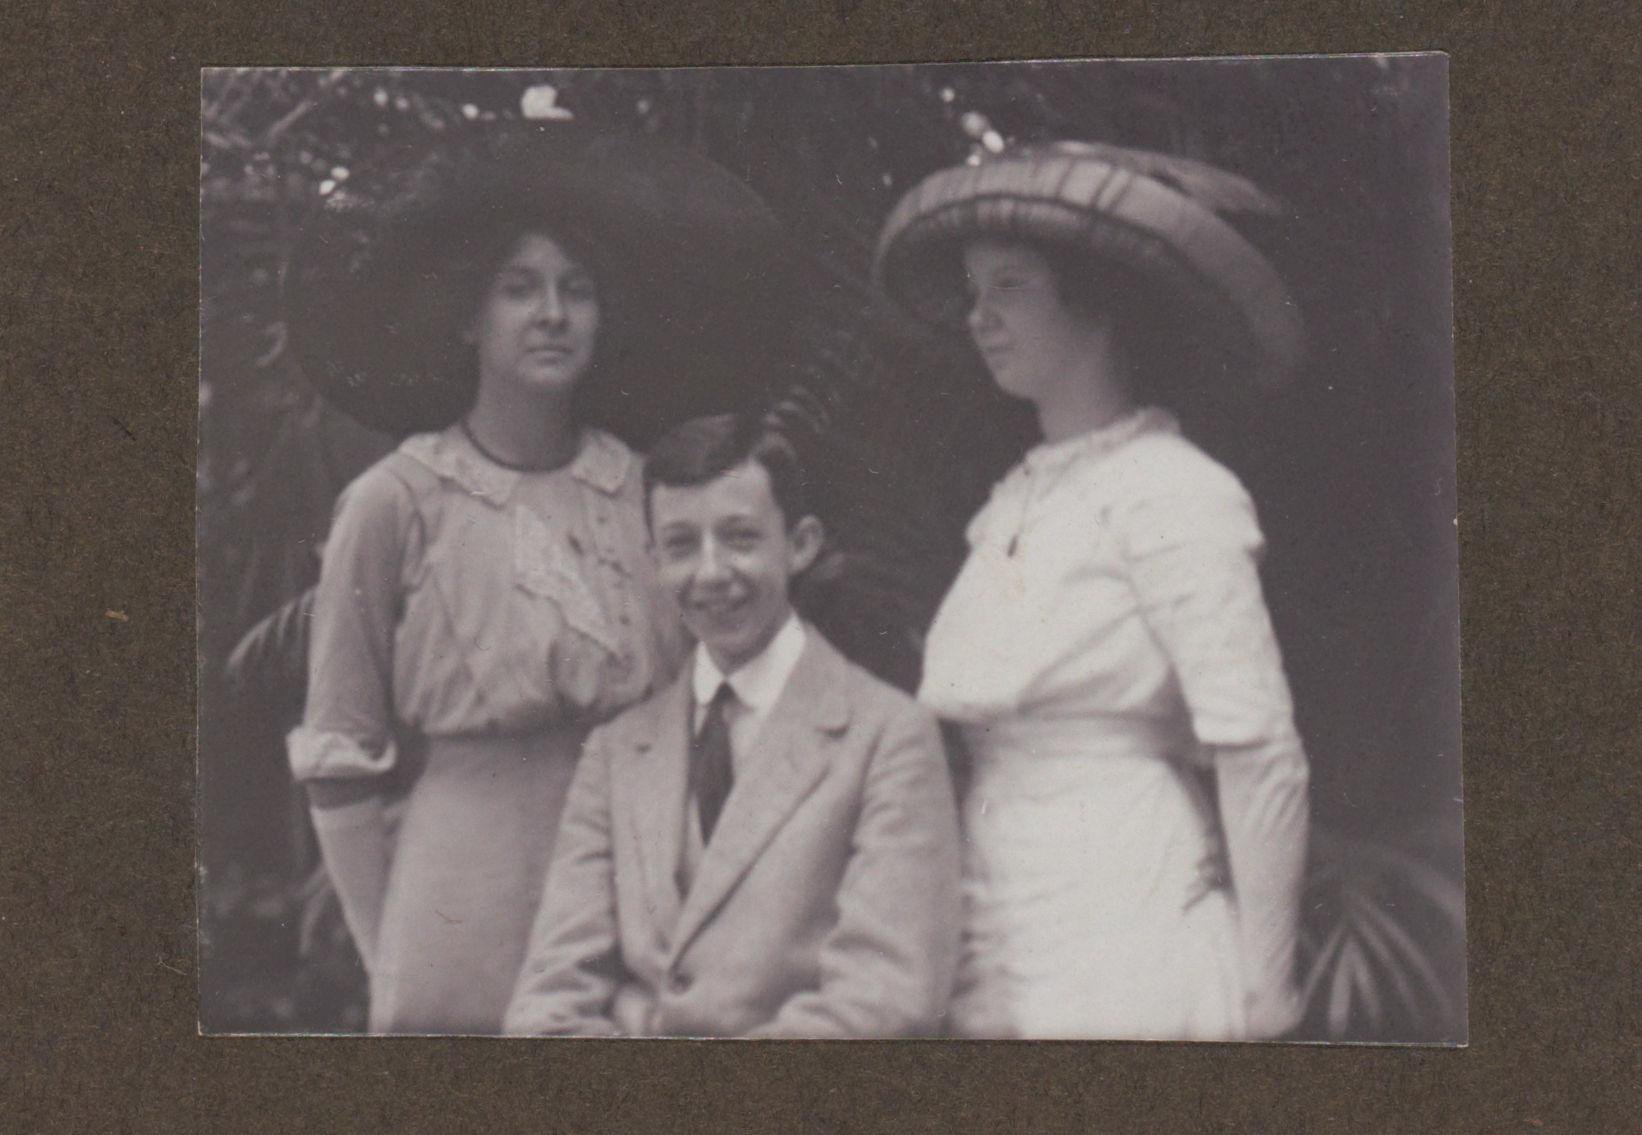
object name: photograph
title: Maria Gonggrijp met een jongen en een jonge vrouw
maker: Anonymous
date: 1910-1914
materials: photographic support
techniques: photography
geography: suriname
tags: suriname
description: Maria Gonggrijp poserend met een jongen en een vriendin. De beide vrouwen dragen een grote zonnehoed. Onderdeel van een groep van elf albumbladen met familiefoto's van de familie Gonggrijp in Suriname, ca. 1912.